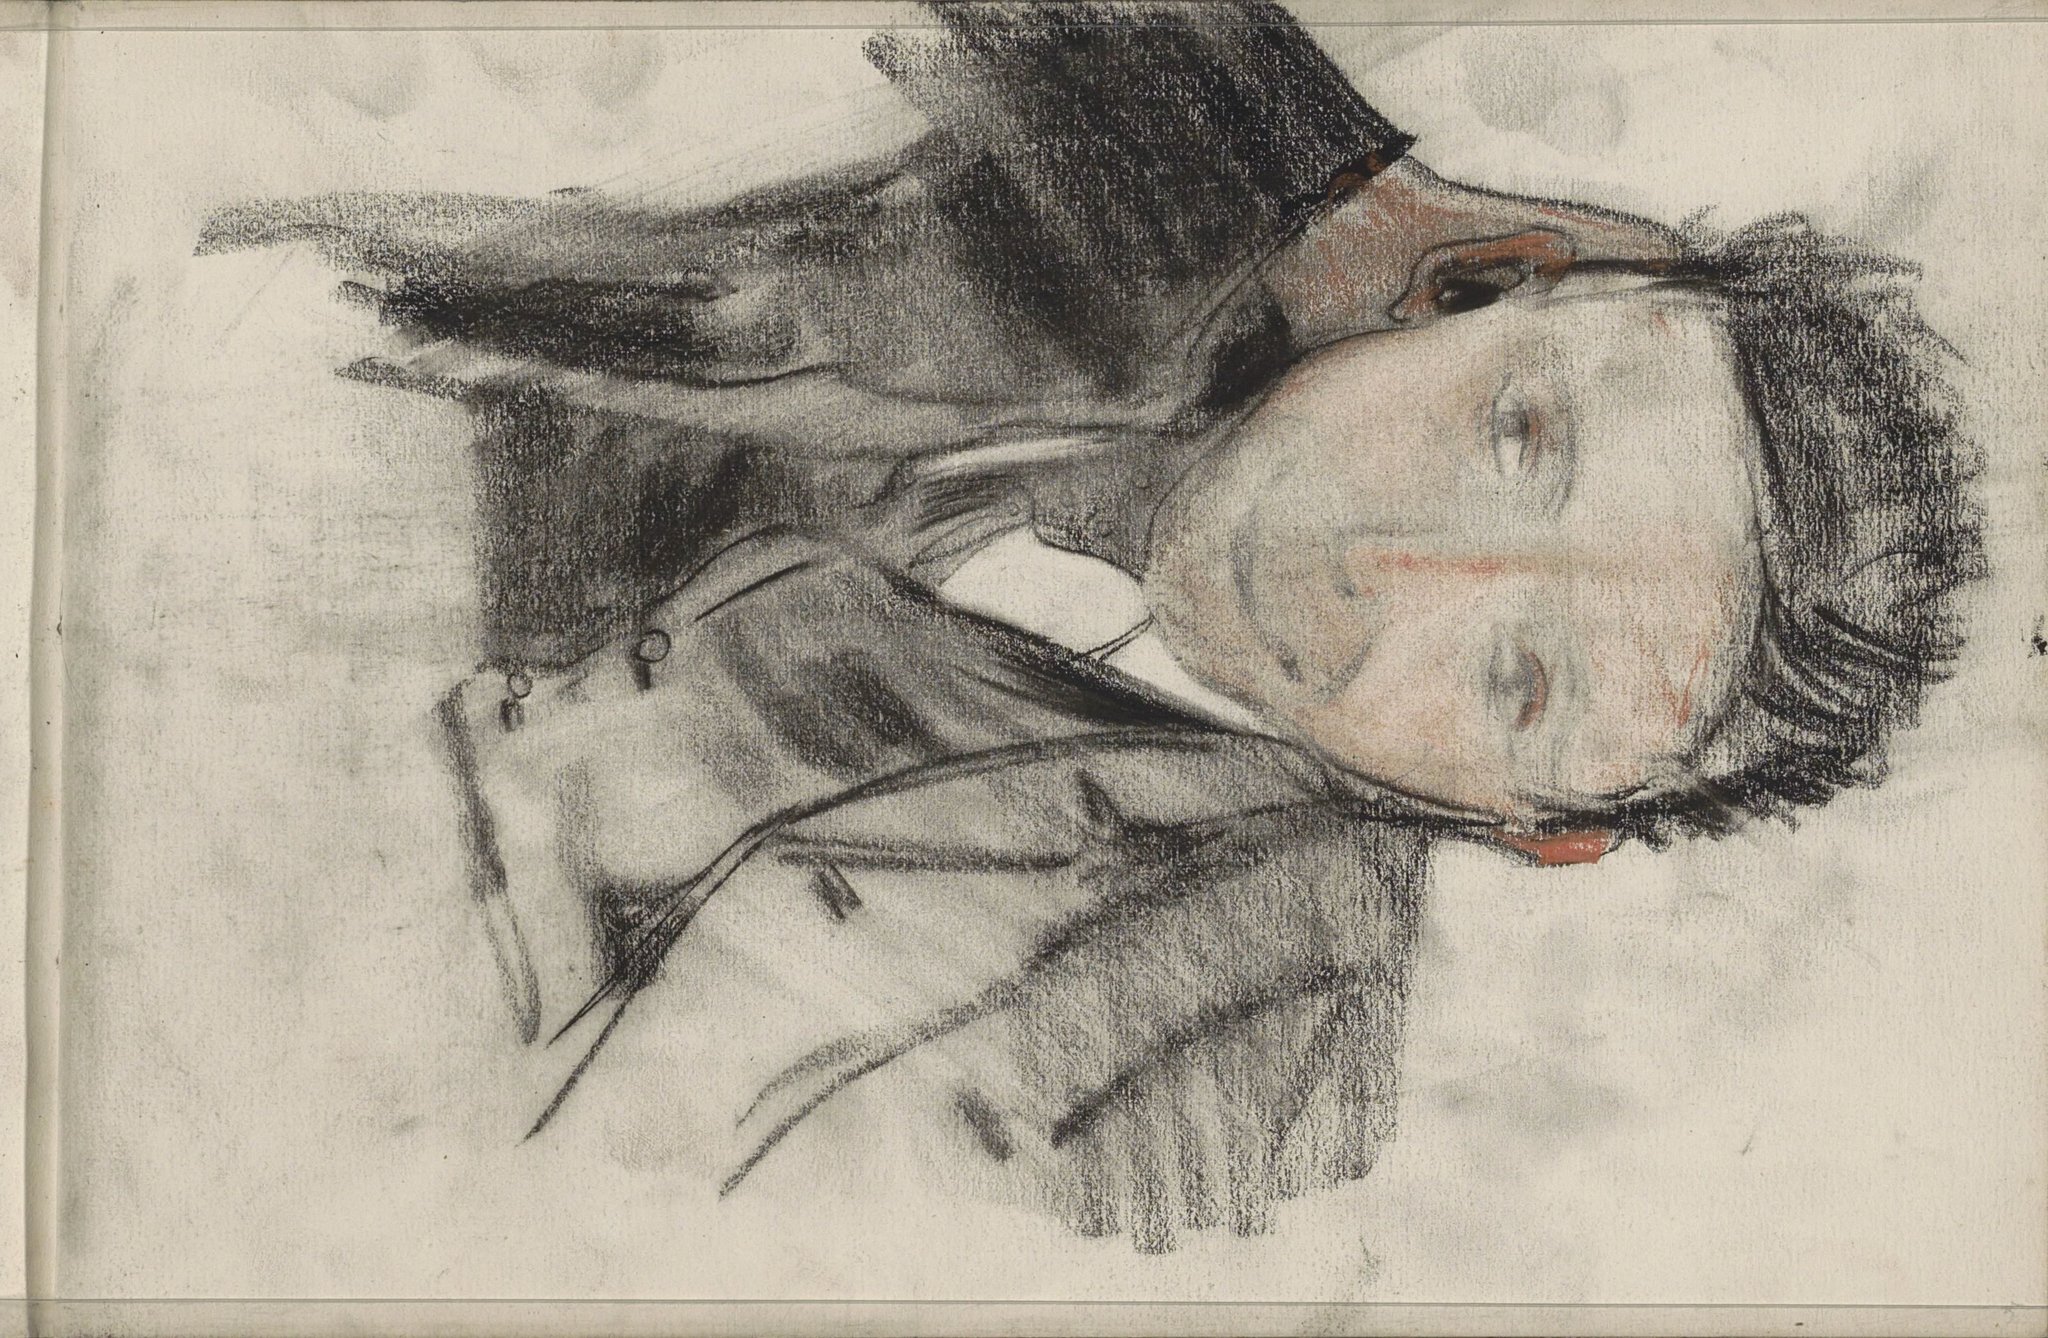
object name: sketchbook leaf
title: Portret van een man in een pak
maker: carel adolph lion cachet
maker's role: draughtsman, print maker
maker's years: 1864-1945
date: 1895-1900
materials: chalk, paper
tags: hand(s) behind the head, adult man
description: De man houdt zijn rechterhand achter zijn hoofd. Blad 5 recto uit een schetsboek met 19 bladen.